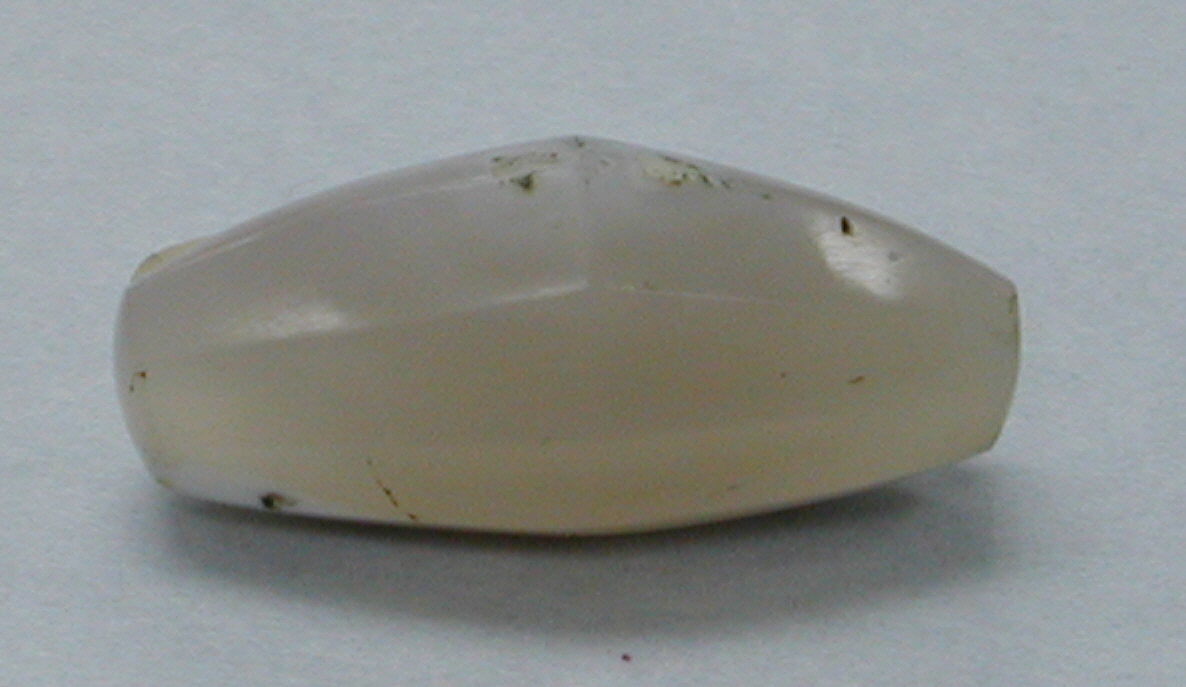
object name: ritual stone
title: Stone Pulidor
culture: mexican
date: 1501-1600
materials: stone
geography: mexico